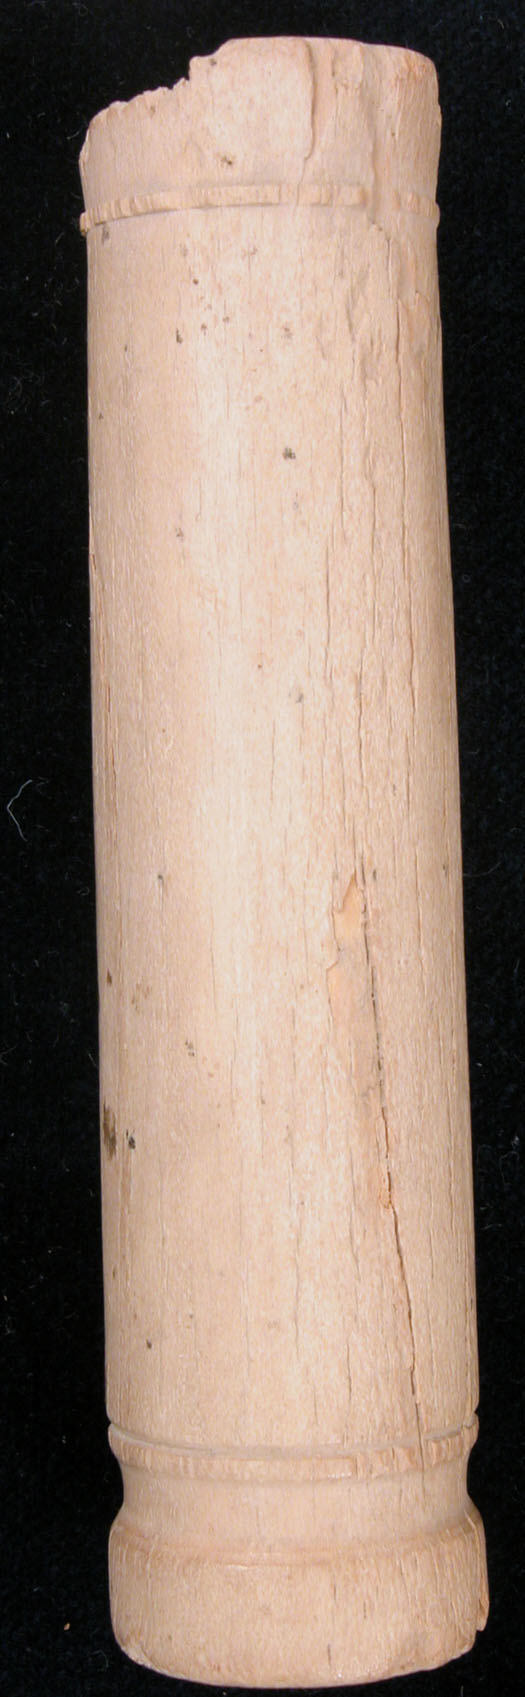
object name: fragment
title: Bone Fragment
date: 401-800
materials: bone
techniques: carving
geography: palestine